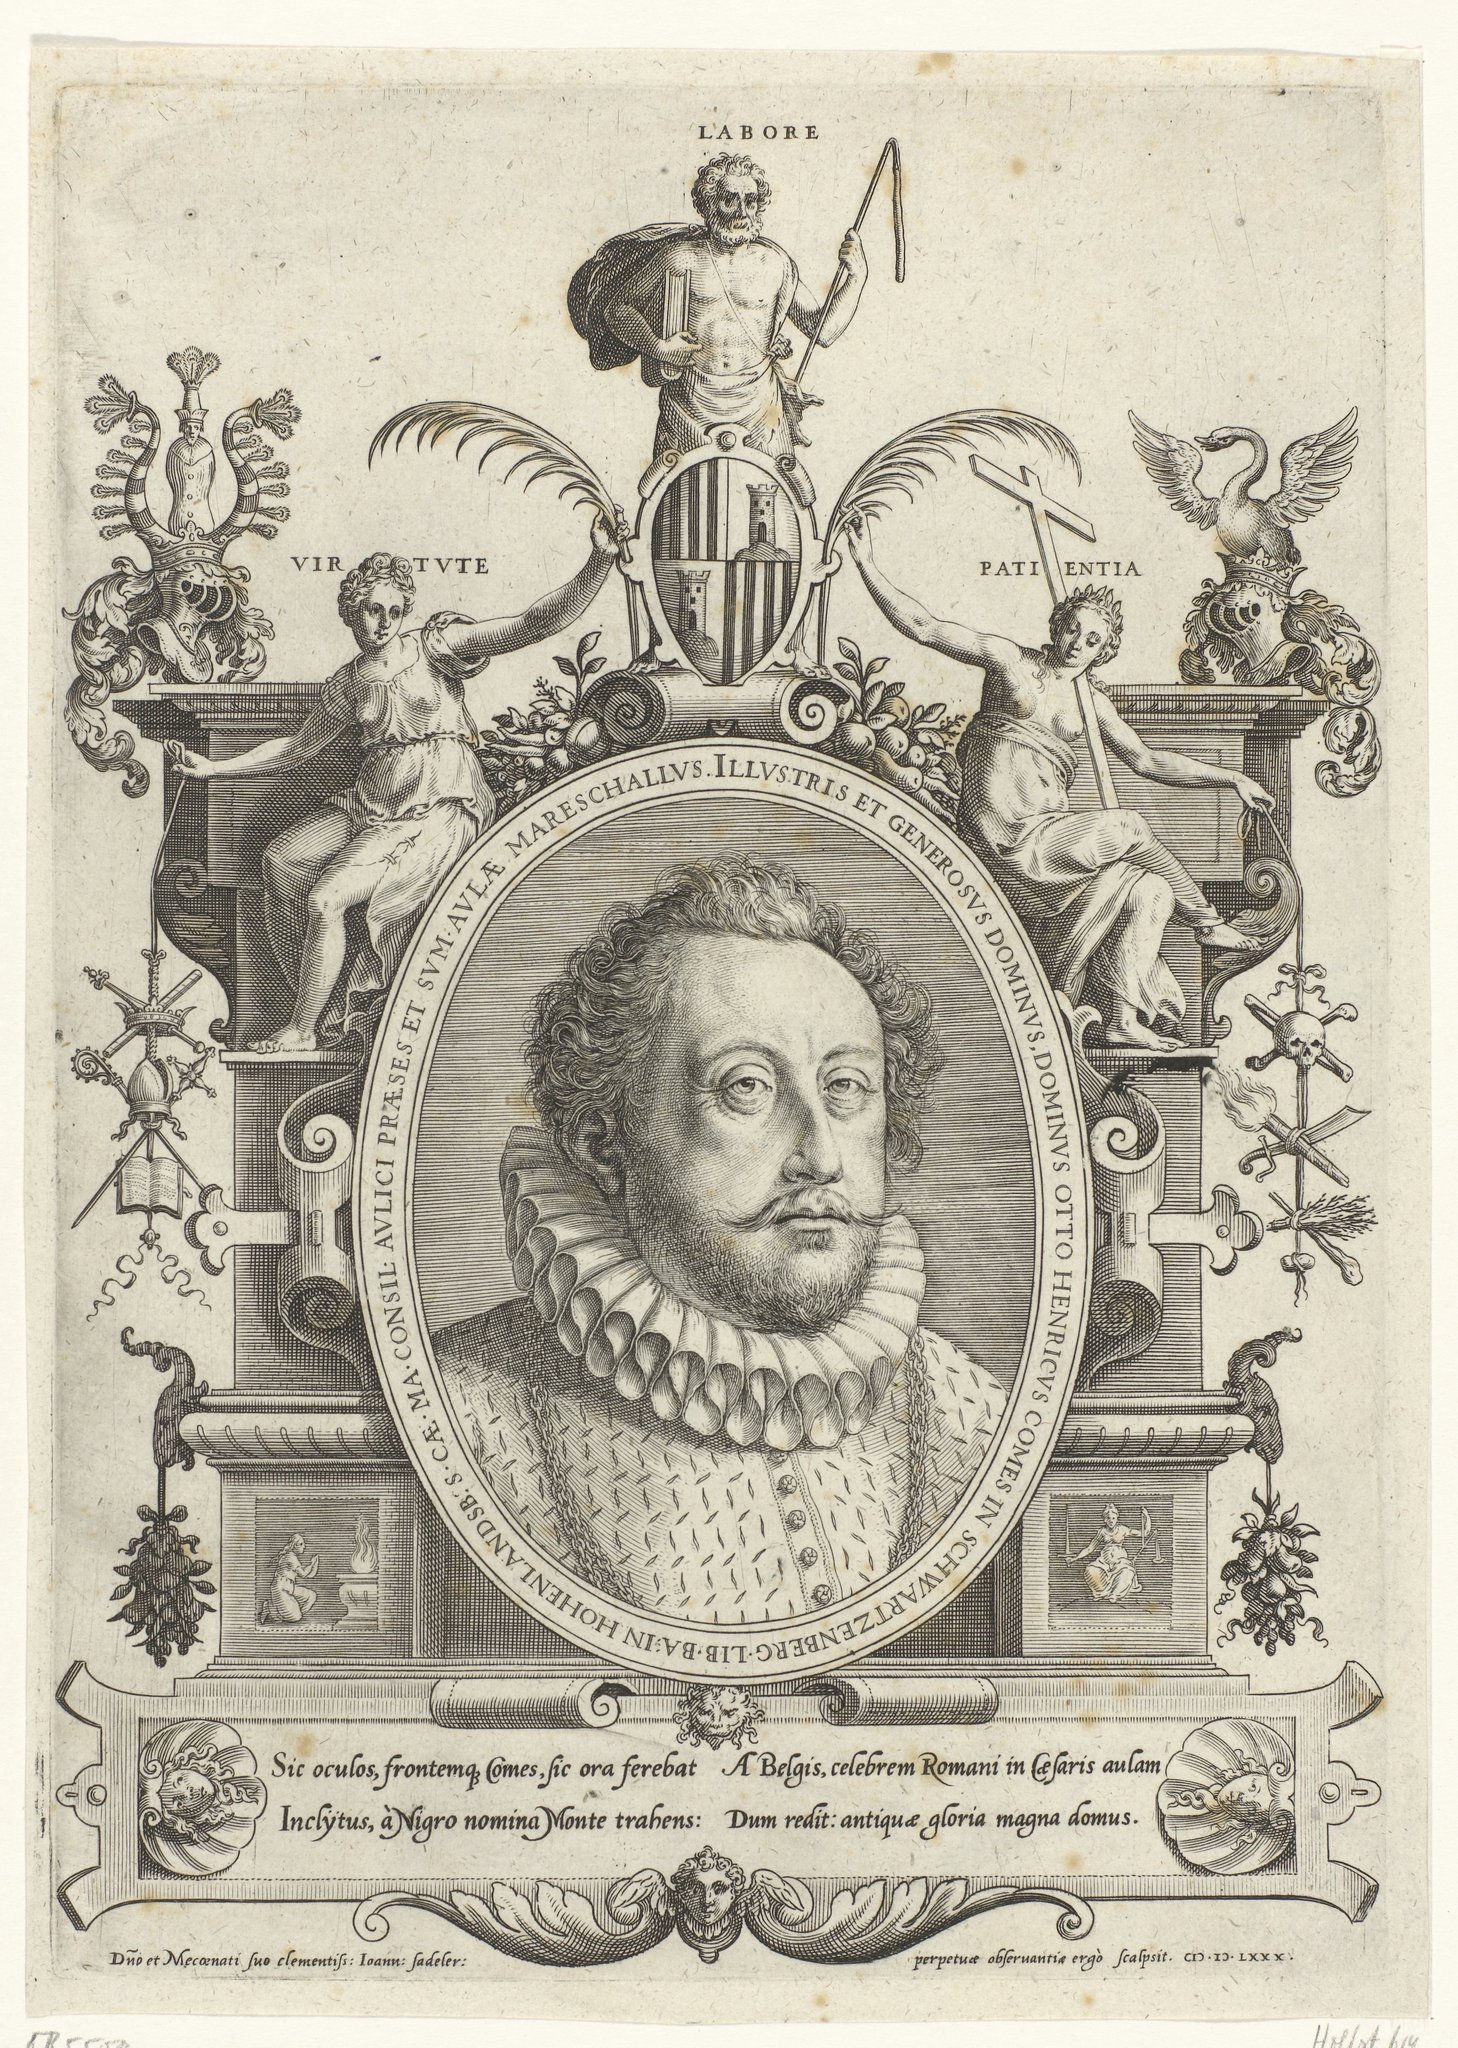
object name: print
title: Portret van Otto Heinrich von Schwarzenberg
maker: johann sadeler (i)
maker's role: print maker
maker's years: 1550-1600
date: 1580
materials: paper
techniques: engraving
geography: cologne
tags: earl, politician, otto heinrich von schwarzenberg, patience; 'patienza' (ripa), ornament ~ cartouche, virtuousness; 'amor di virtù', 'attione virtuosa', 'guida sicura de' veri honori', 'virtù', 'virtù insuperabile' (ripa), labour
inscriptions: collector's mark: Lugt 240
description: Otto Heinrich van Schwartzenberg, Keizerlijke commisaris in Keulen en adviseur van hertog Willem van Beieren. Rondom het portret een cartouche met bovenaan de personificaties Deugd (Virtute), Arbeid (Labor) en Geduld (Patientia). Onder de cartouche een Latijnse tekst.